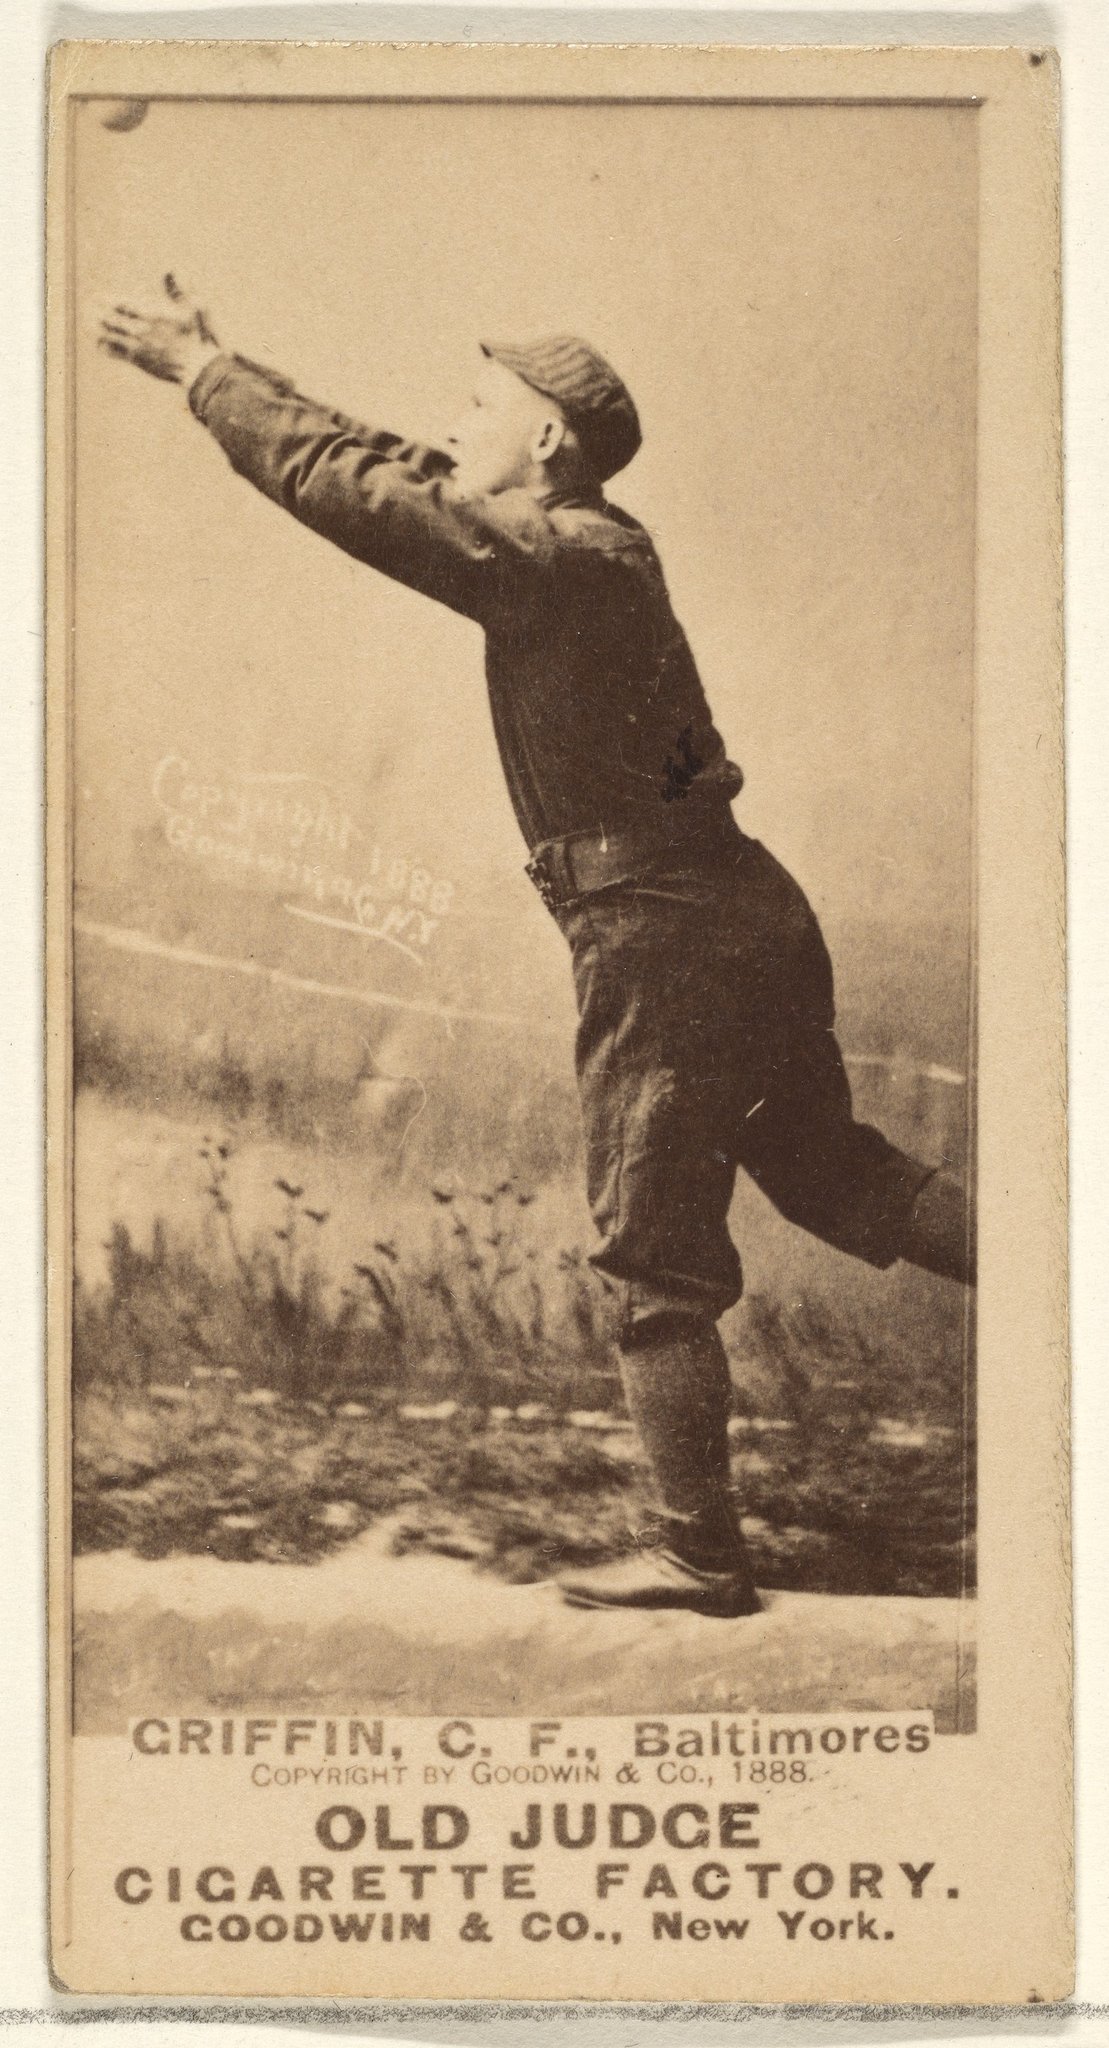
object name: baseball card, photograph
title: Griffin, Center Field, Baltimore Orioles, from the Old Judge series (N172) for Old Judge Cigarettes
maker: goodwin & company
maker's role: publisher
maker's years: 1850-1950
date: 1888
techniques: albumen silver print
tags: men,portraits,baseball,athletes